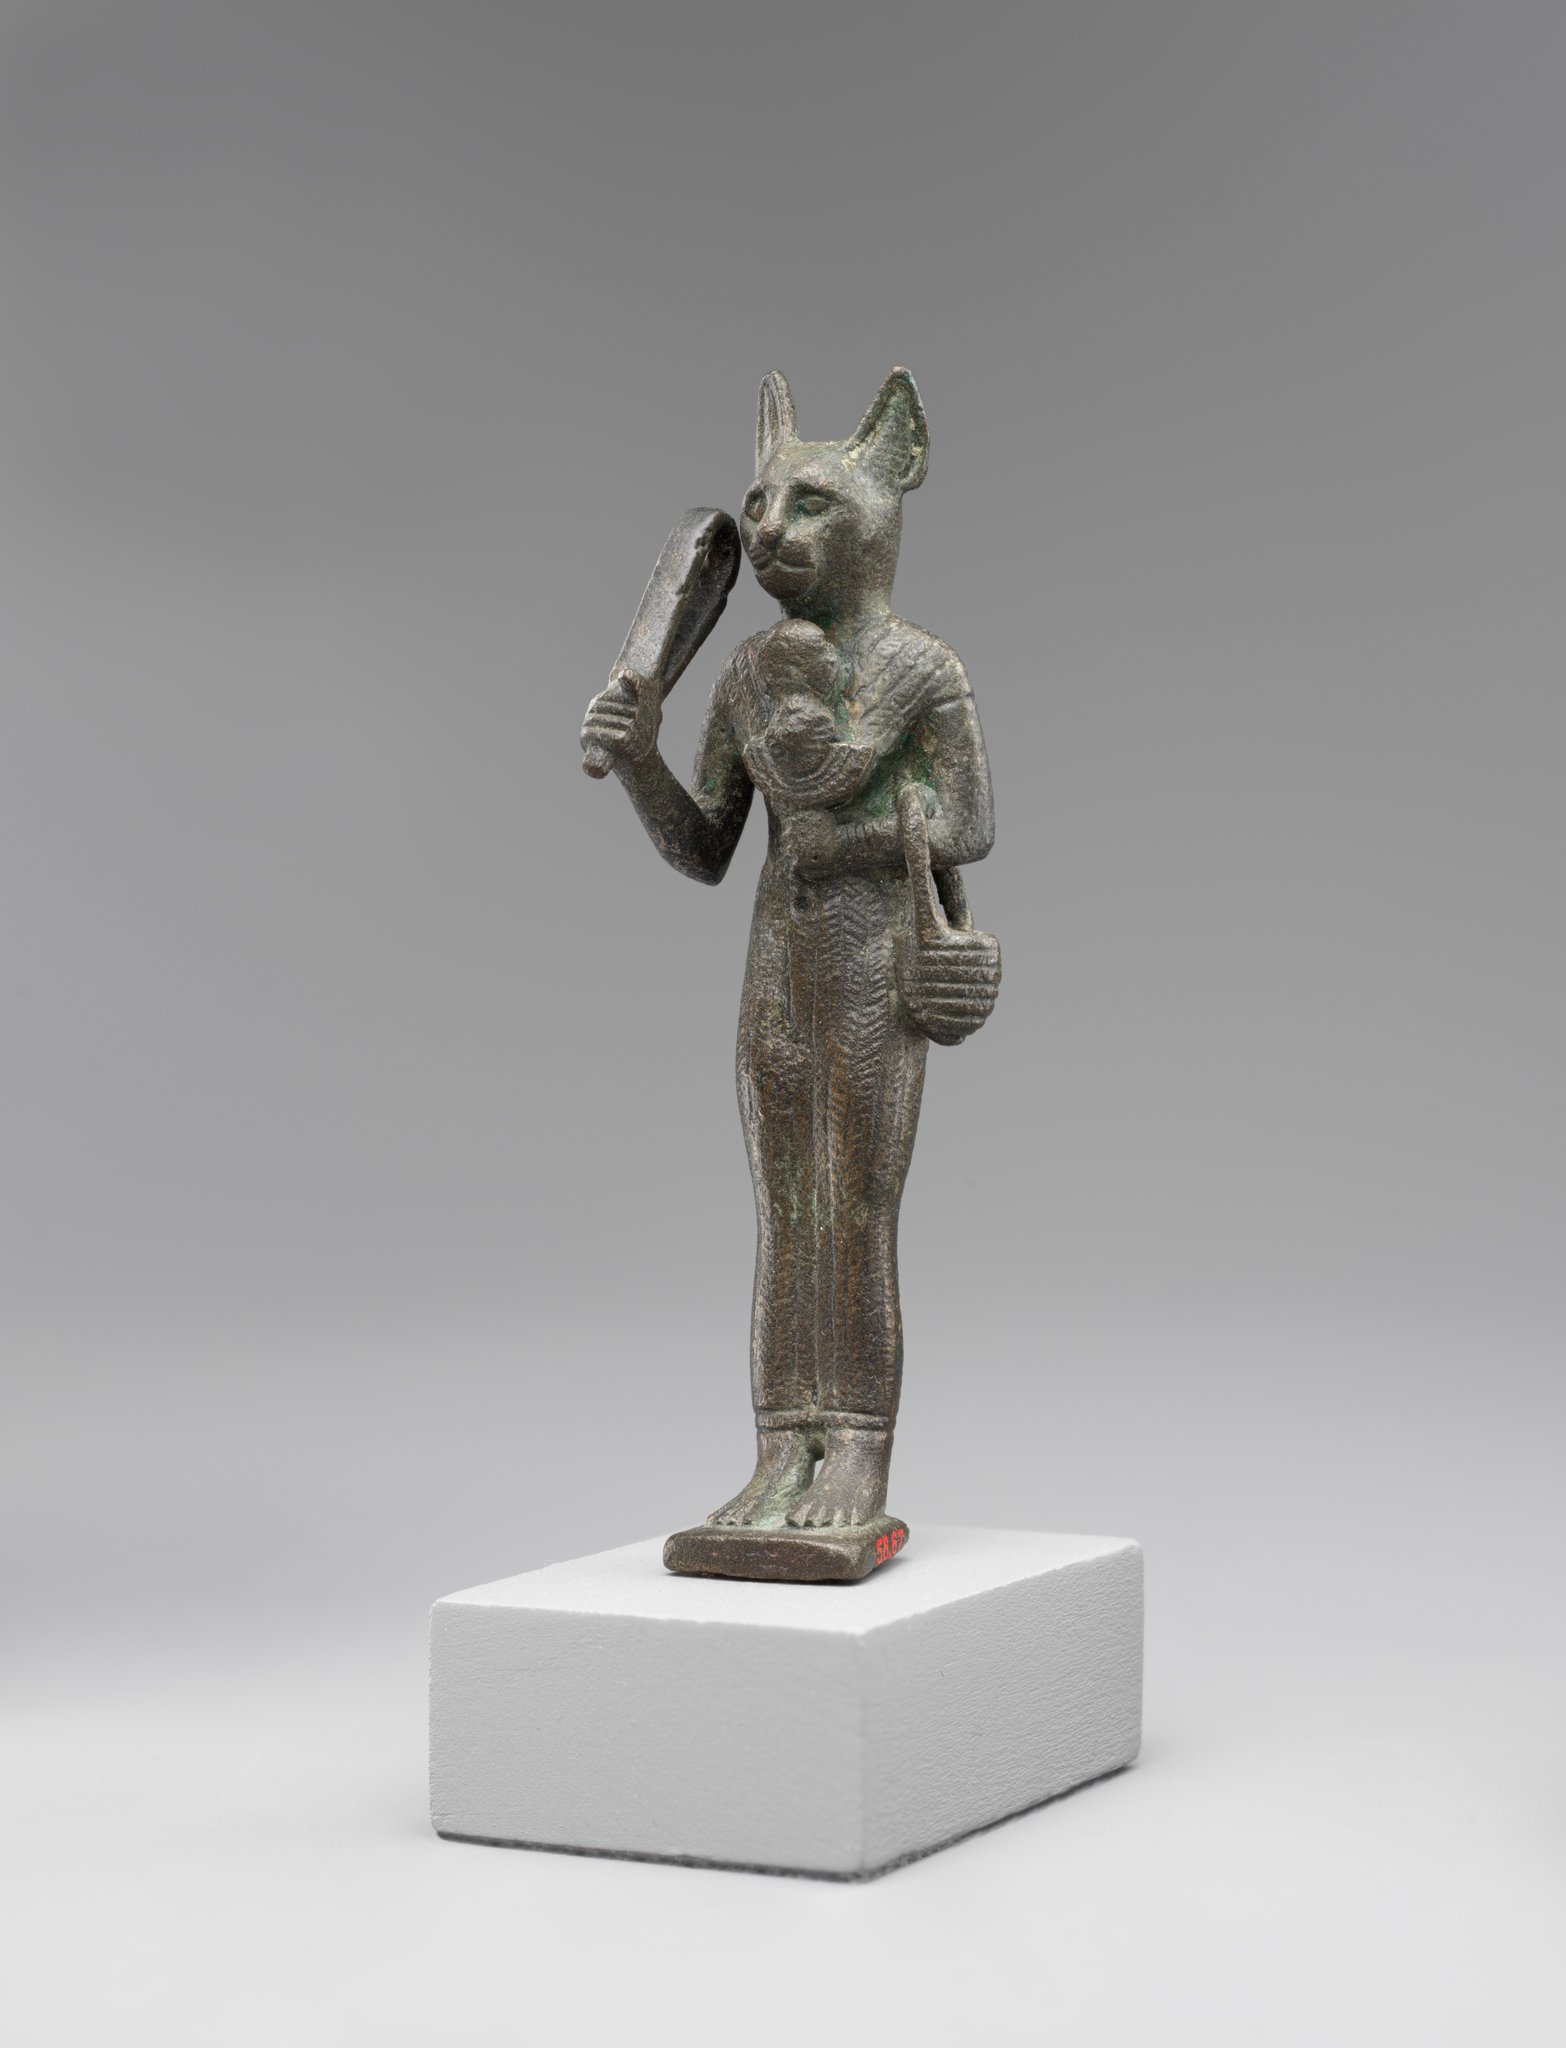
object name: statuette, bastet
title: Statuette of cat-headed Bastet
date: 664-630 BCE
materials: metal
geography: egypt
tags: goddess